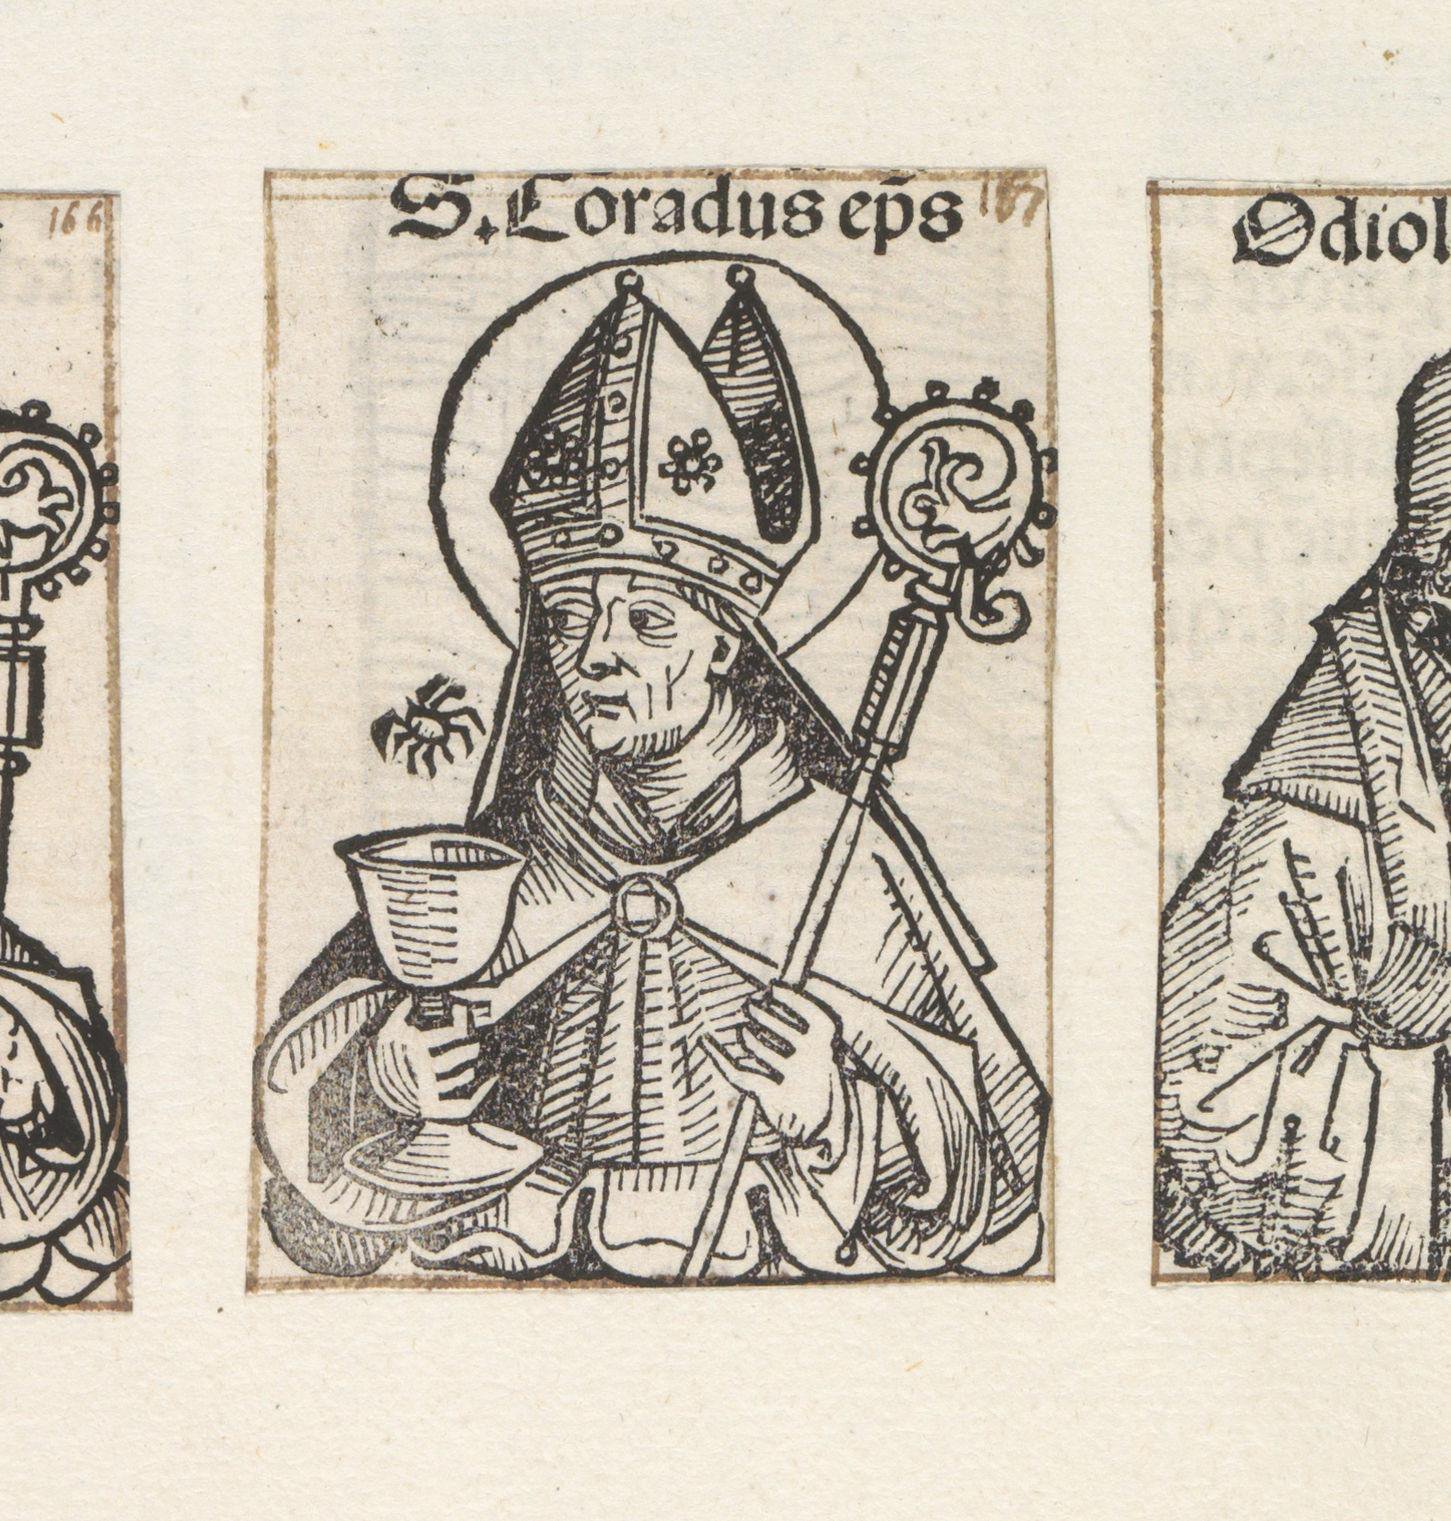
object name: book illustration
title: S. Co[n]radus ep[iscopu]s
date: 1493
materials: paper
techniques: letterpress printing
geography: nuremberg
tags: archbishop, bishop, etc. (roman catholic), saints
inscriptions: inscription: ‘167’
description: Een bloemkelk met een bisschop. Hij heeft een kromstaf in zijn linkerhand en een kelk met spin in zijn rechterhand. De tekst identificeert de man als Koenraad van Konstanz. De prent maakt deel uit van een album.